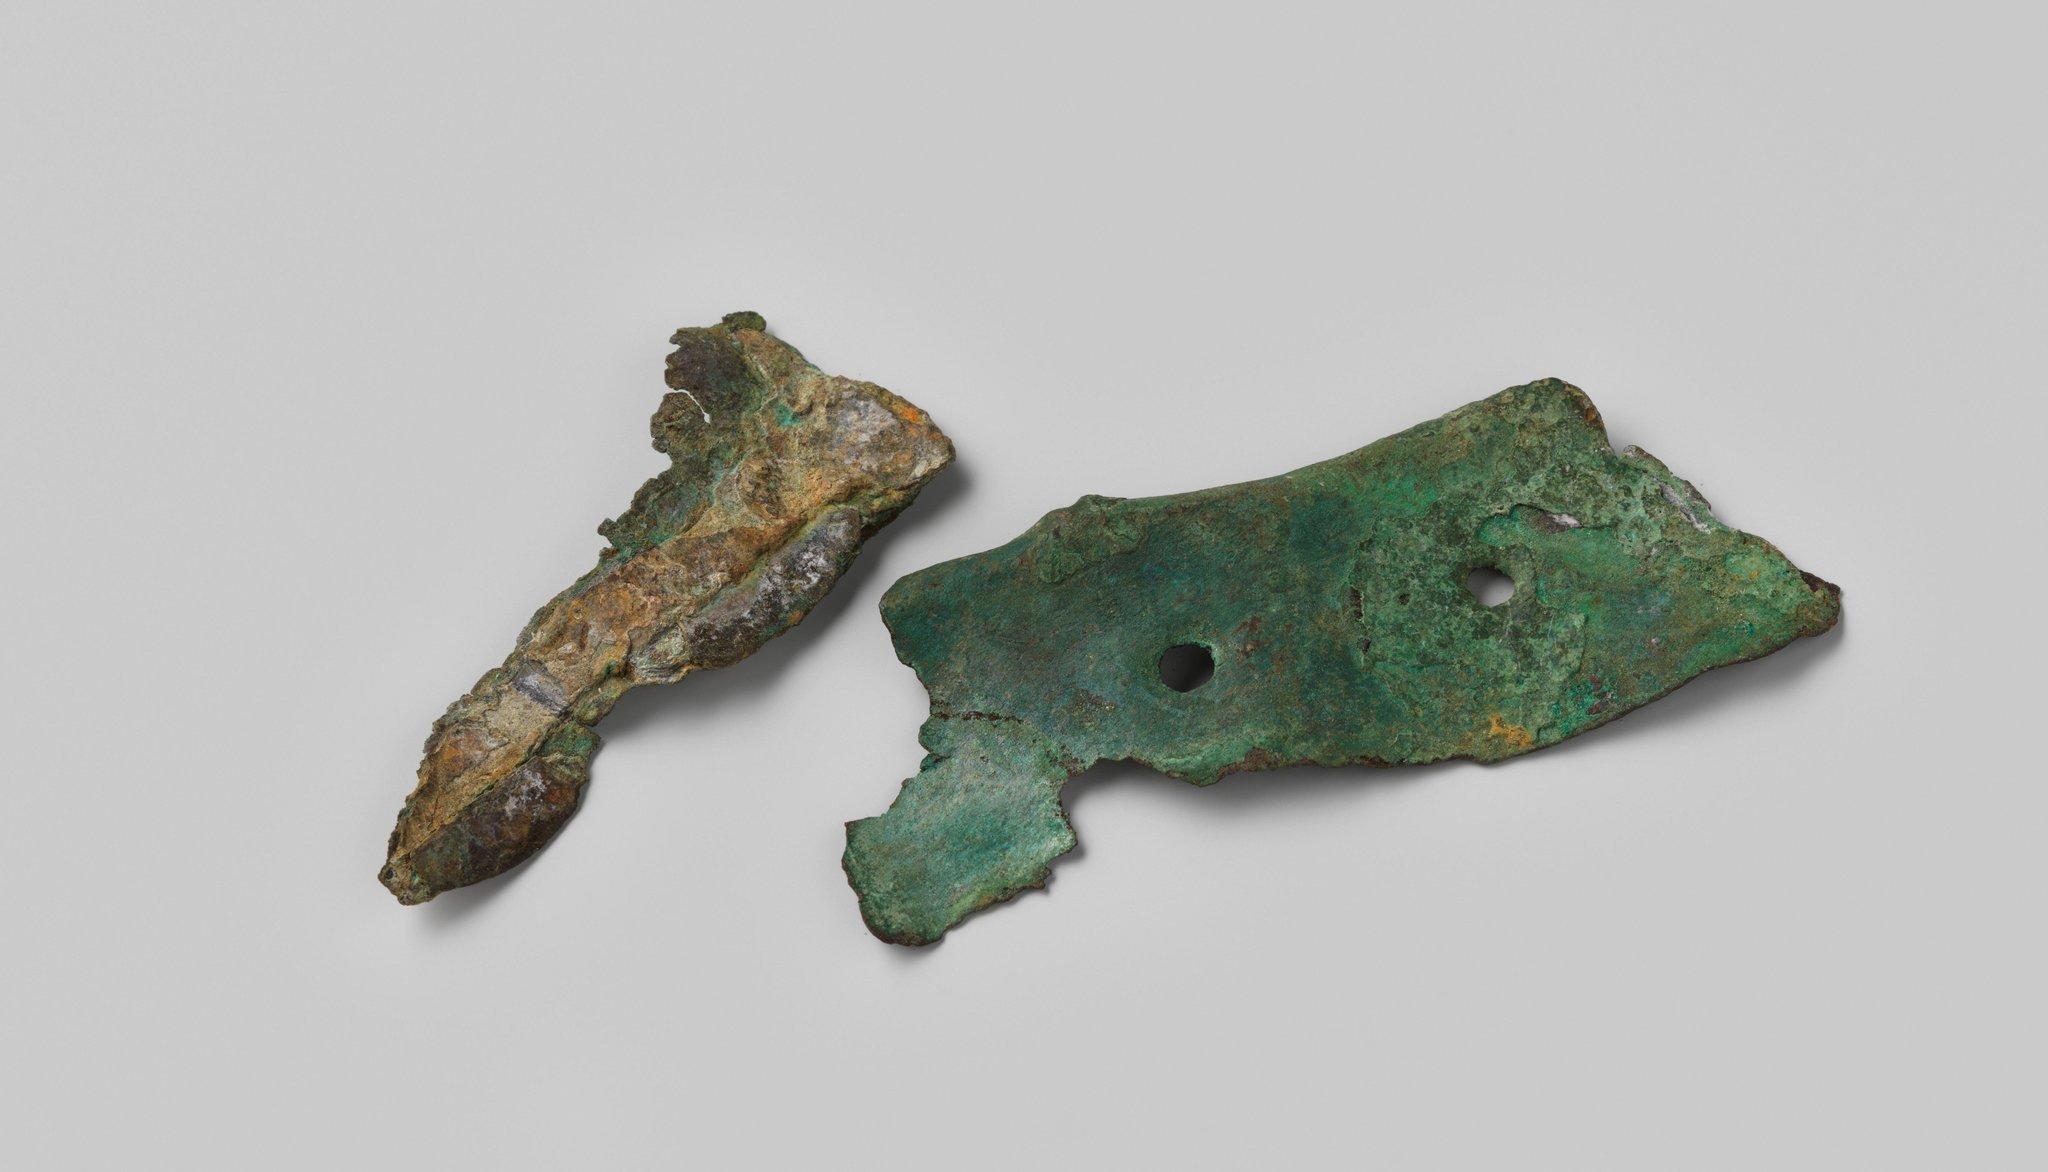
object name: fragment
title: Fragmenten koperen plaatwerk uit het wrak van de Oost-Indiëvaarder Hollandia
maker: Anonymous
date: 1700-1743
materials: copper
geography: netherlands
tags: verenigde oostindische compagnie, hollandia (schip), annet